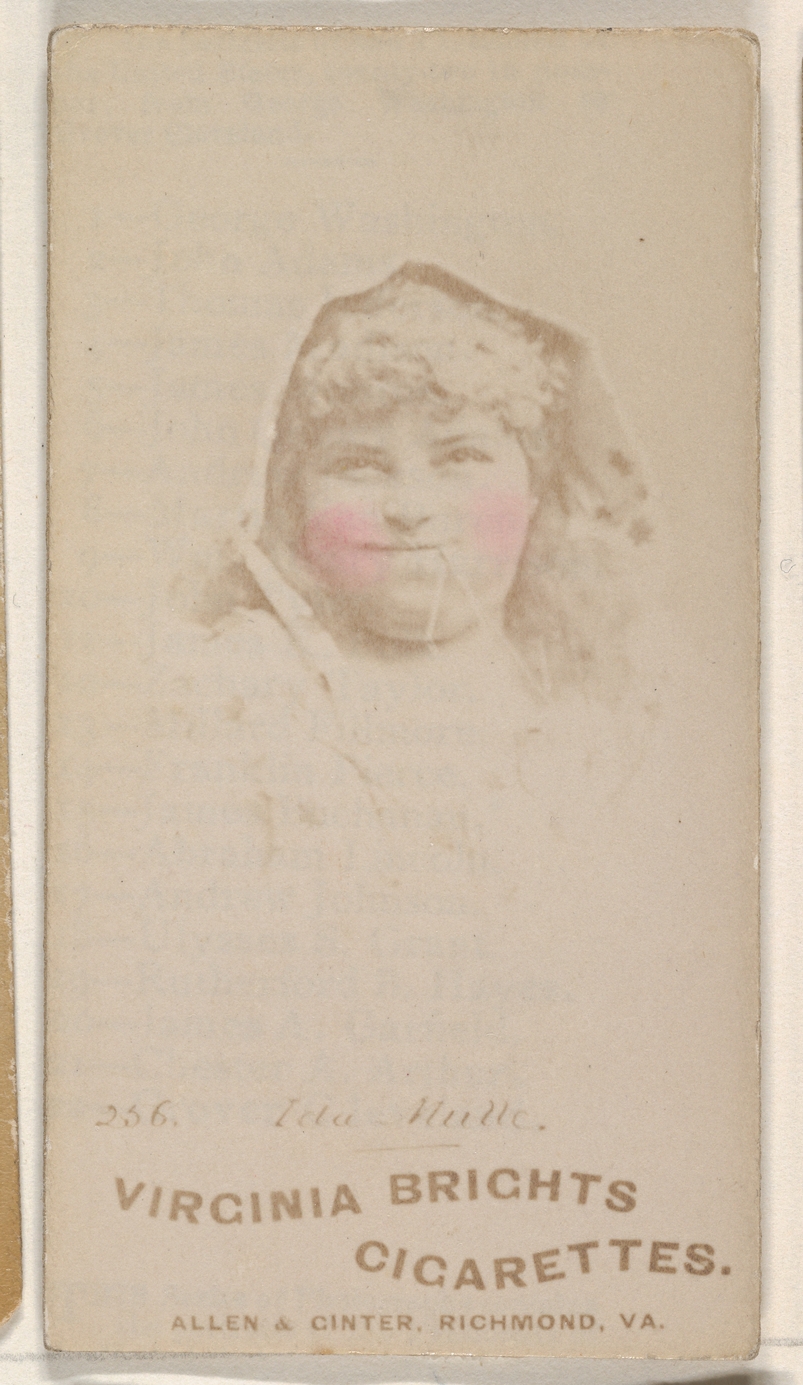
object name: photograph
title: Card 256, Ida Mulle, from the Actors and Actresses series (N45, Type 1) for Virginia Brights Cigarettes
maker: allen & ginter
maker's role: publisher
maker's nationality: american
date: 1888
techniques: albumen silver print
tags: portraits,women,actresses